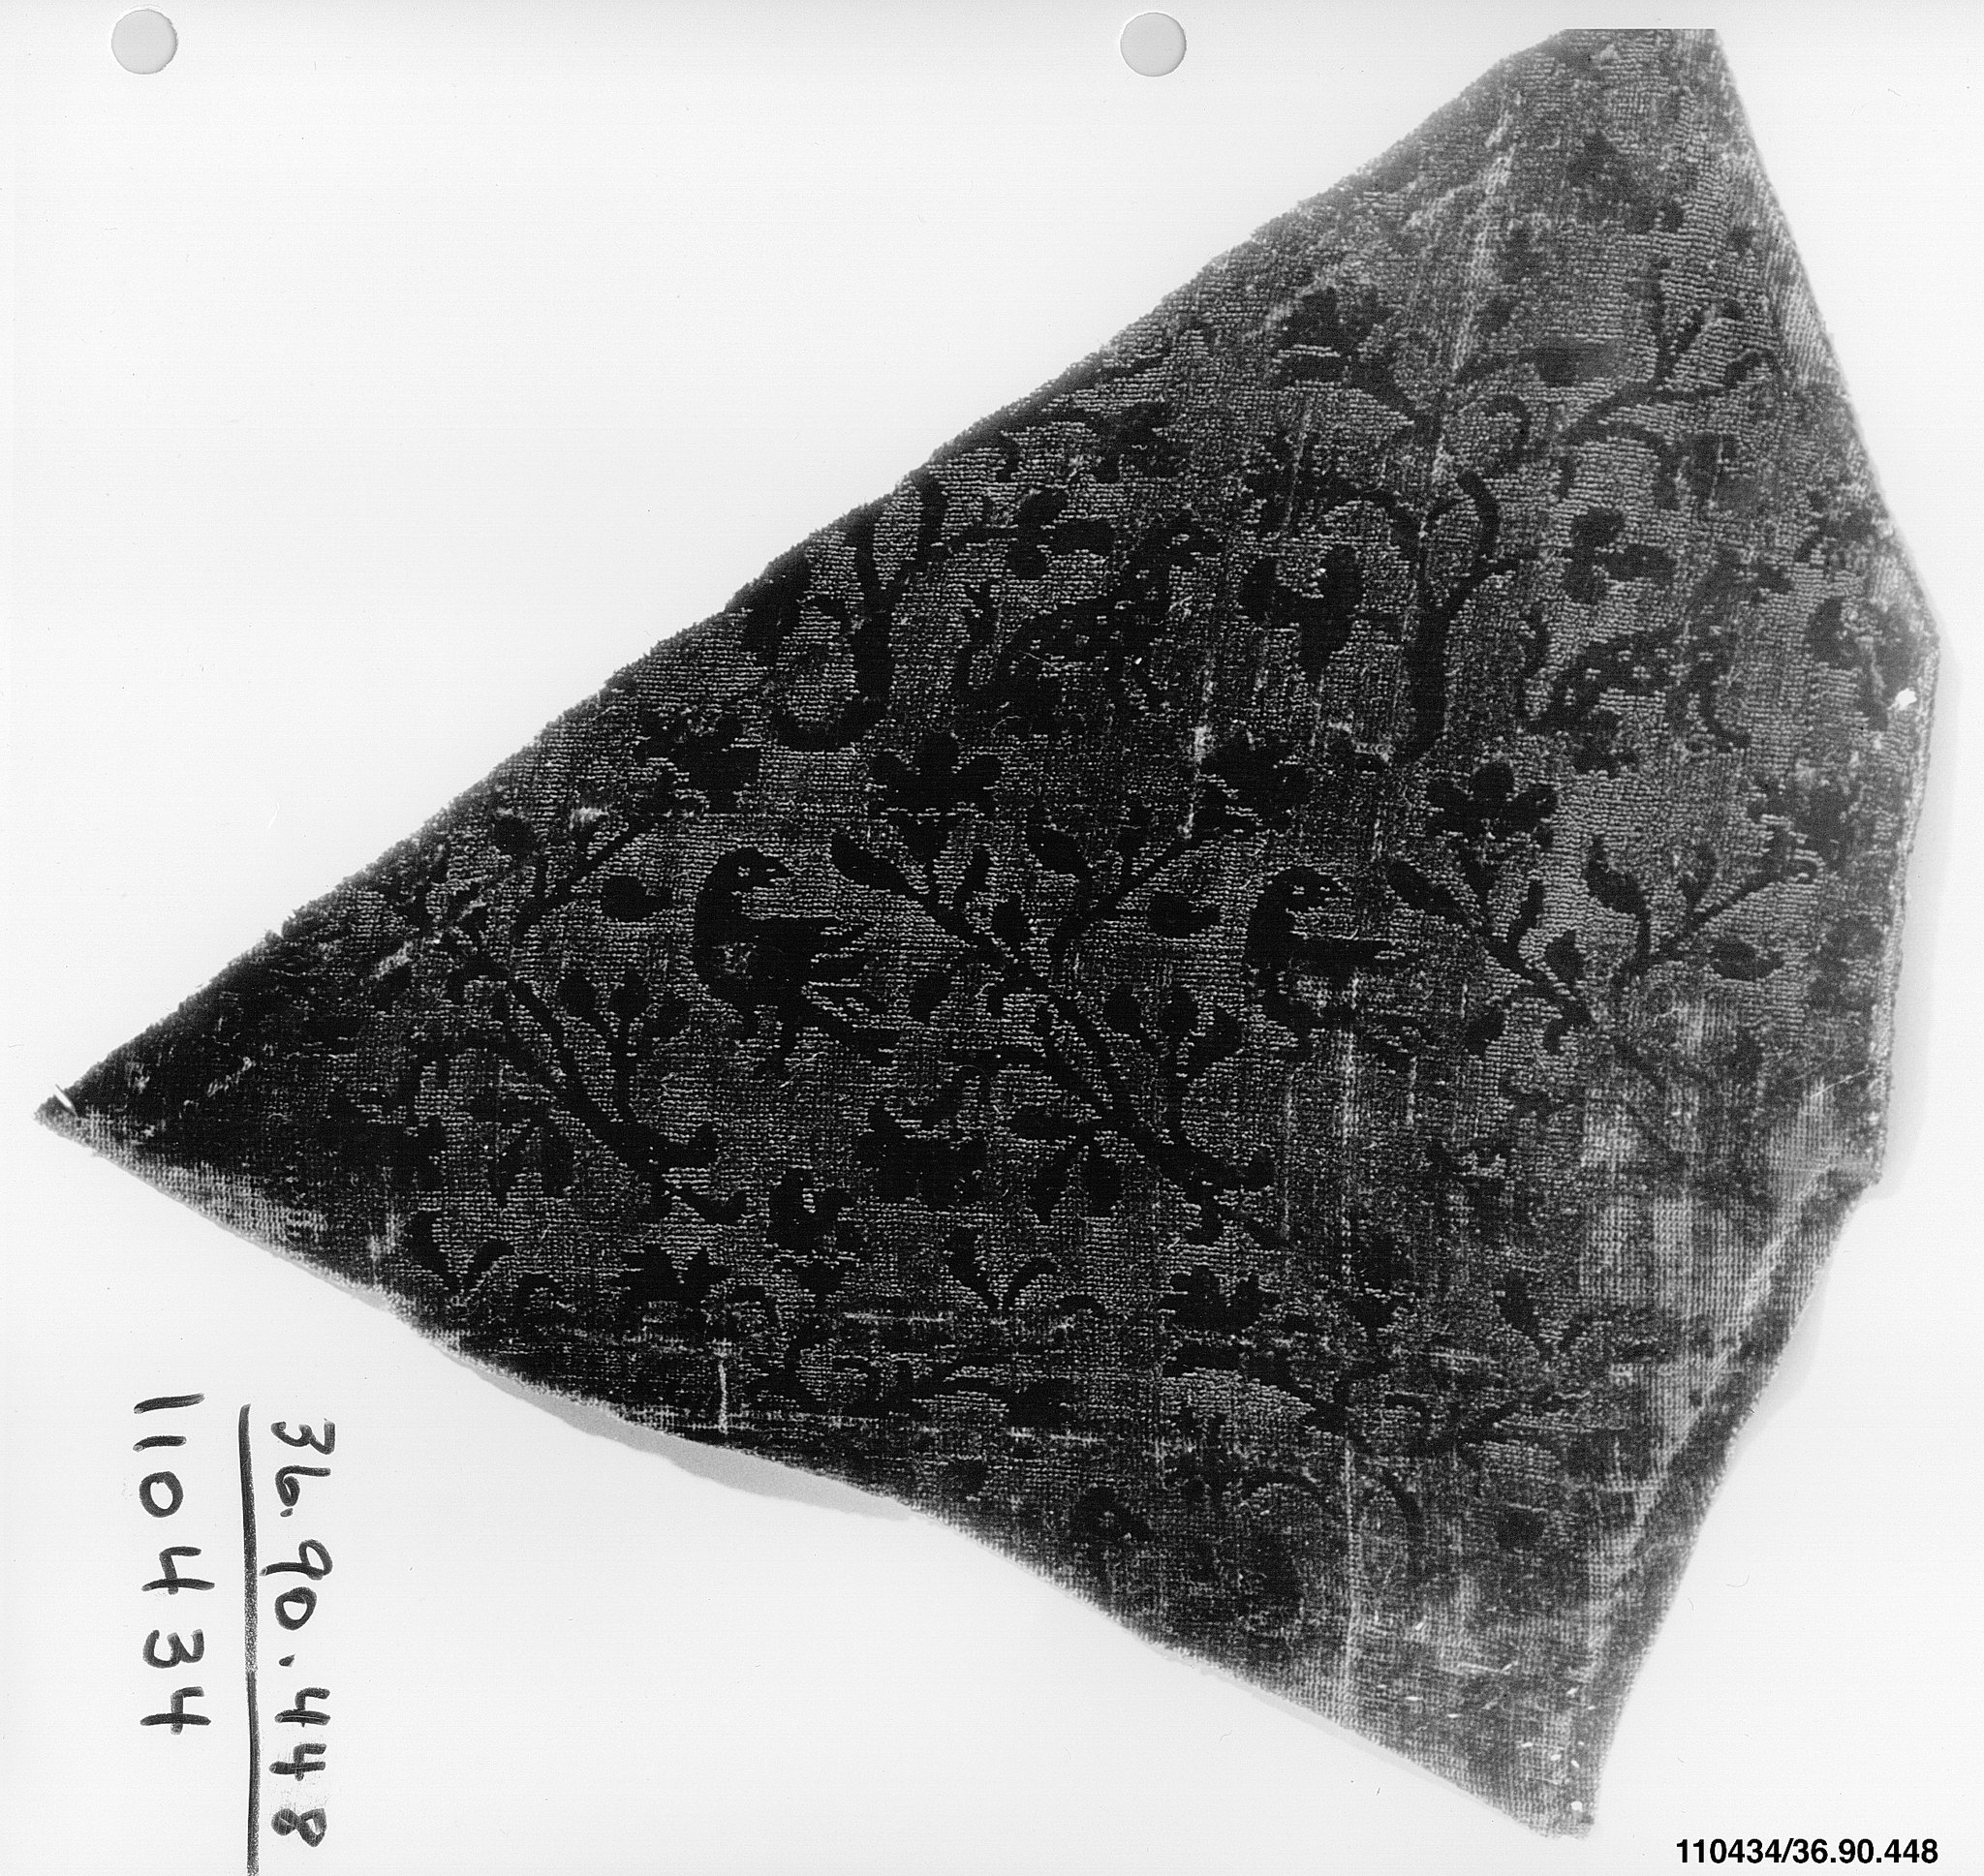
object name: piece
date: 1501-1700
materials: silk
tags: birds,flowers,leaves